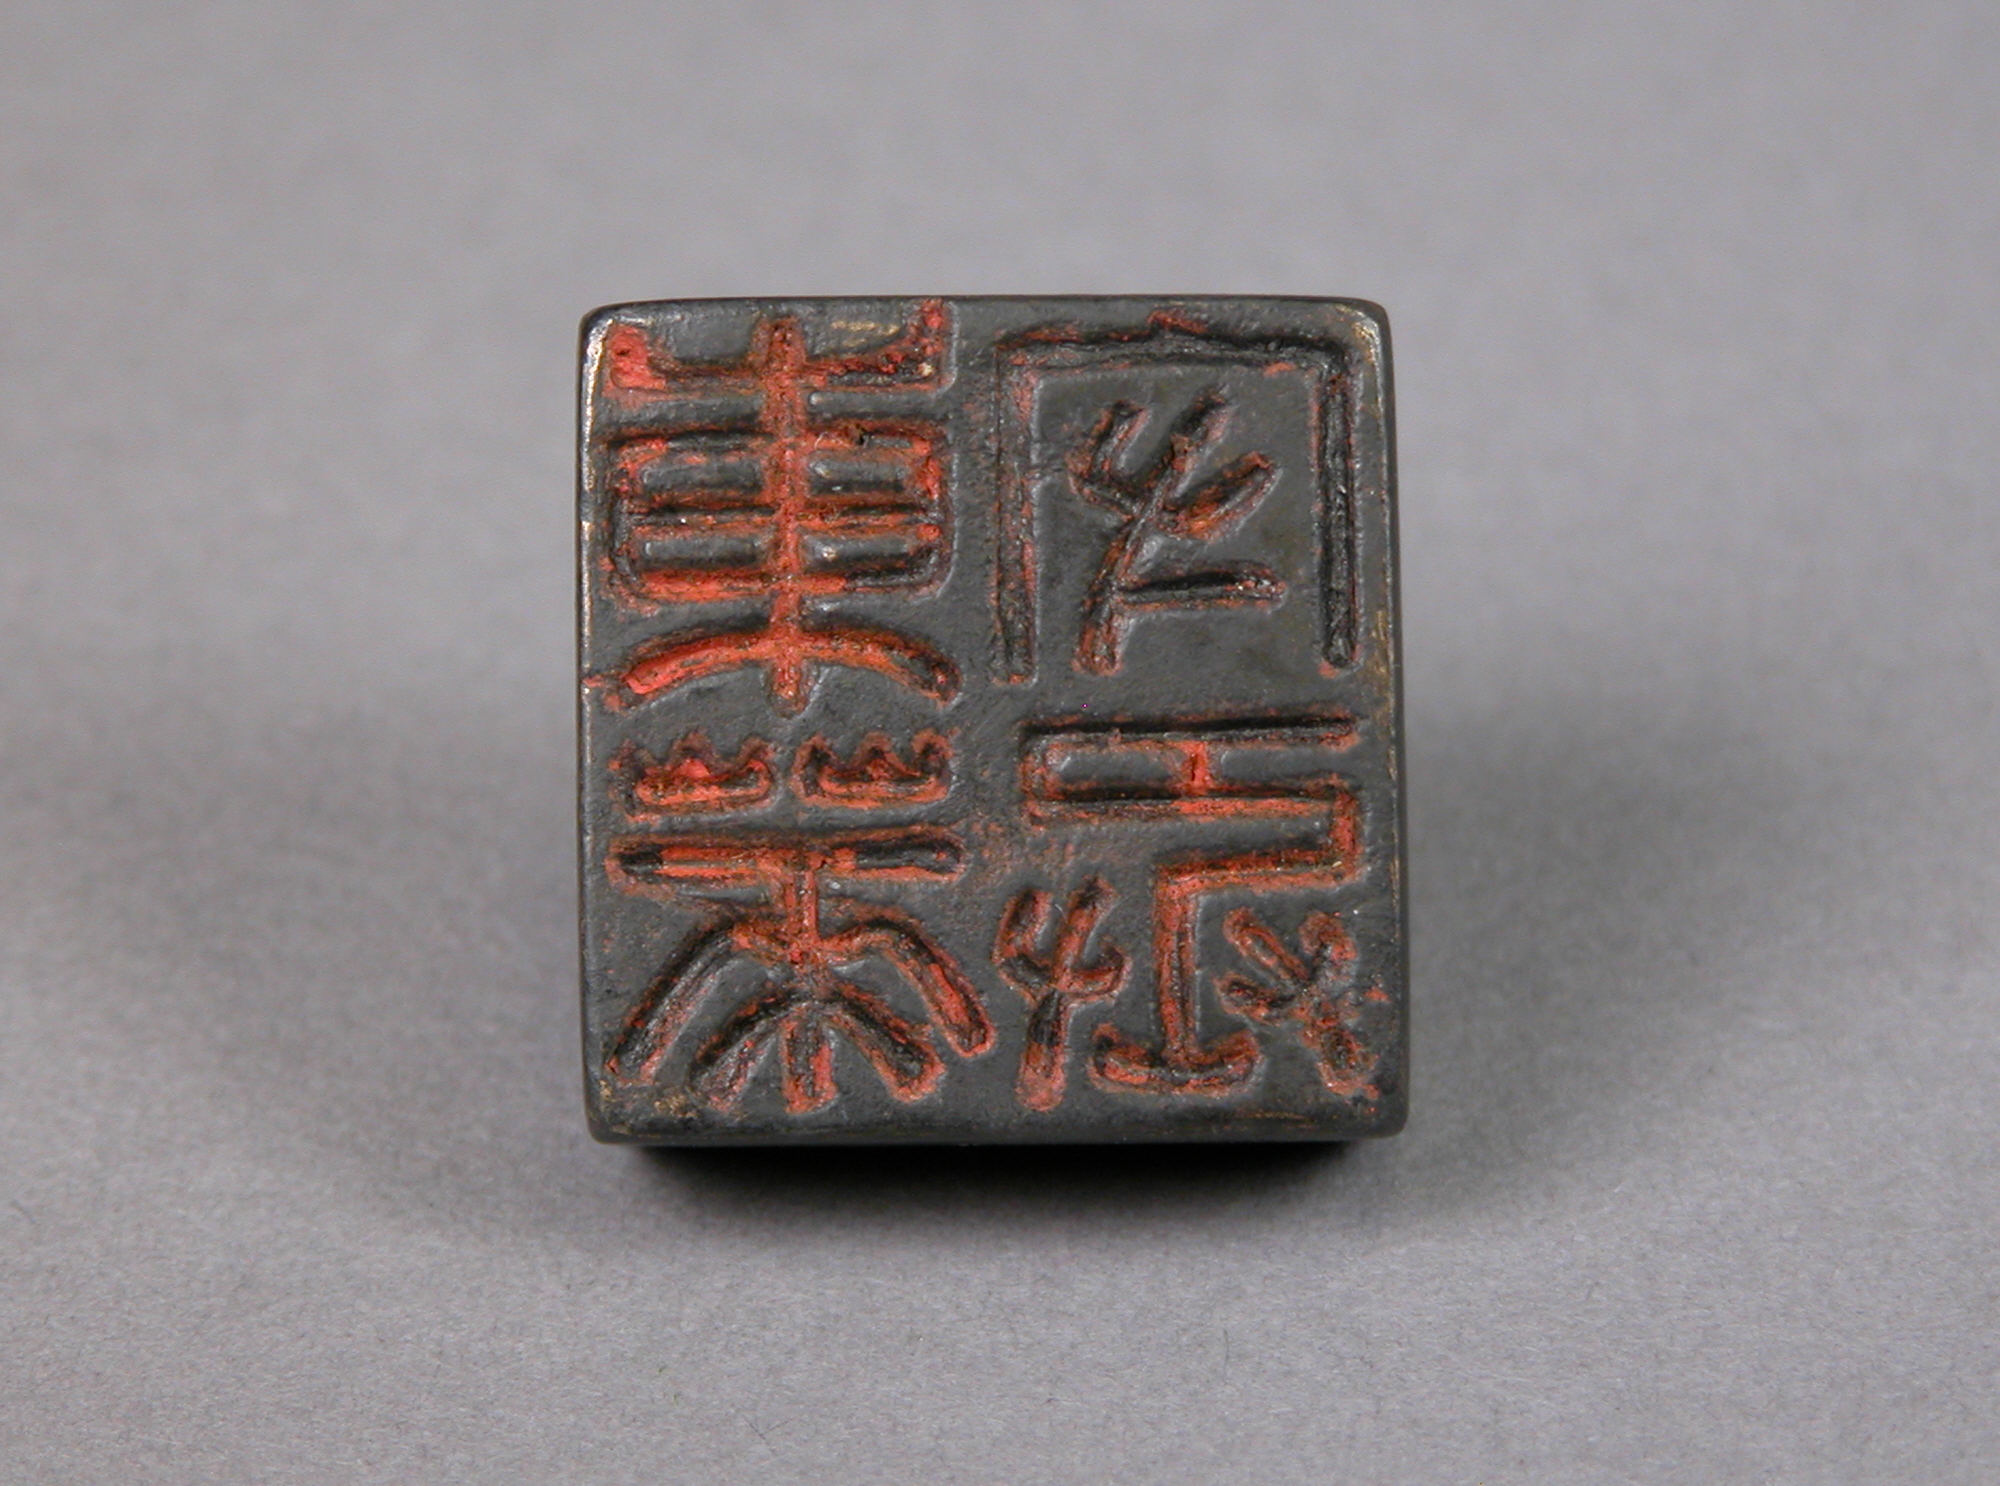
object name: seal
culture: chinese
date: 1300-1644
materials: bronze